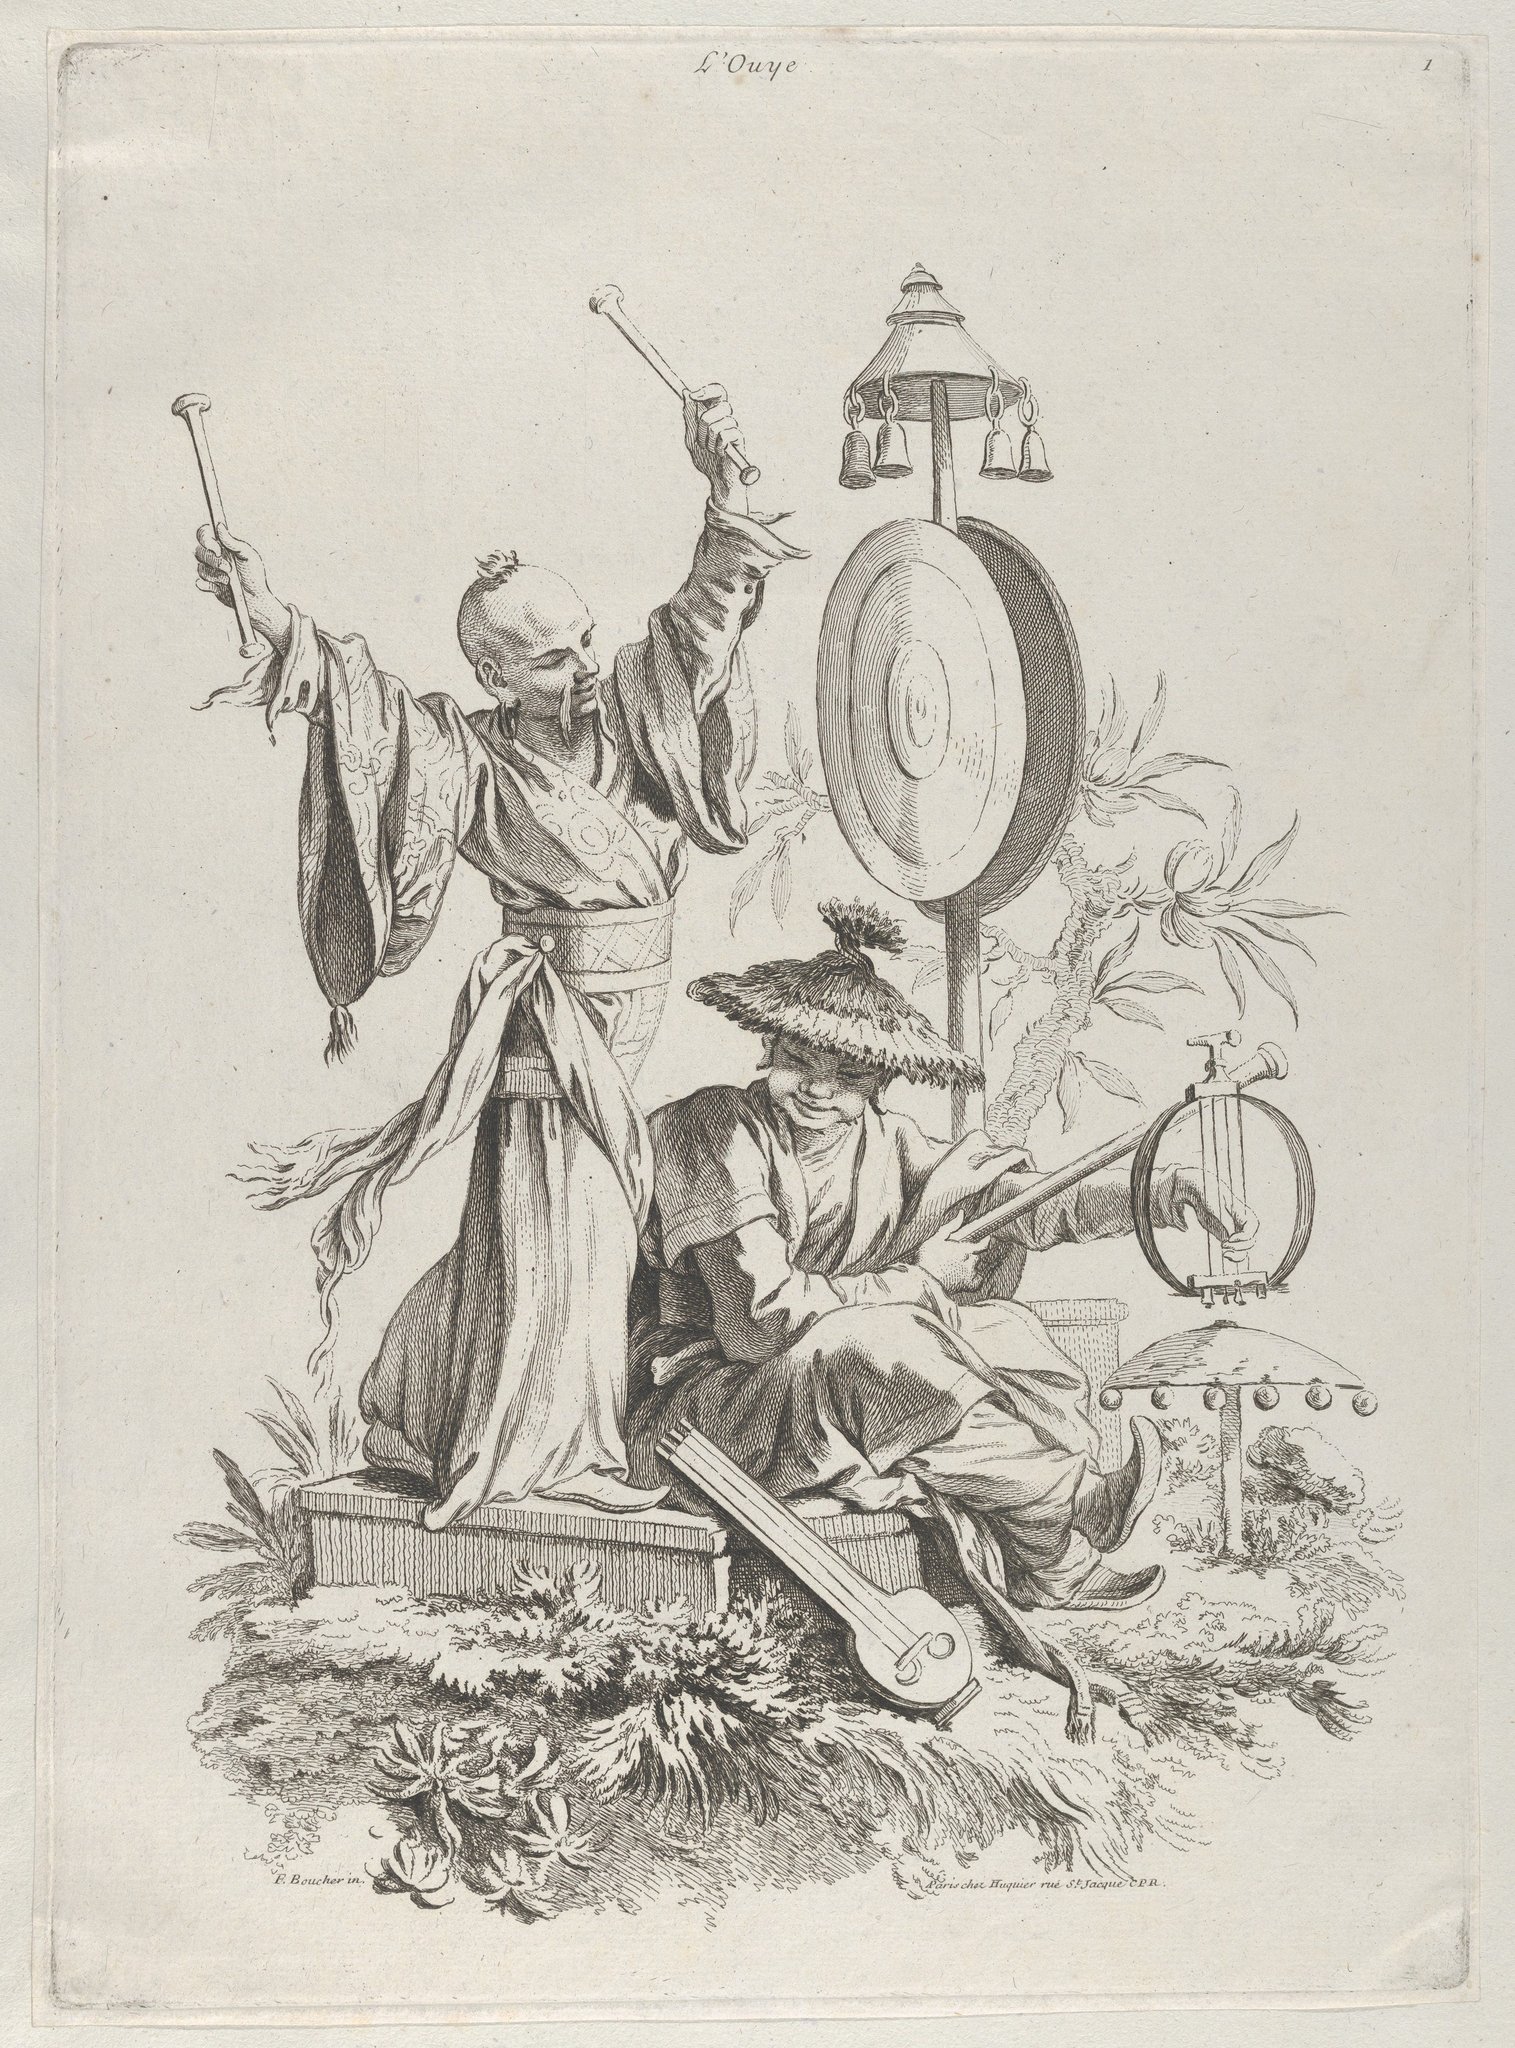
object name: print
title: Hearing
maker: françois boucher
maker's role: artist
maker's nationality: french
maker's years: 1703-1770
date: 1720-1770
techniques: engraving, etching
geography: france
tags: musical instruments,men,musicians